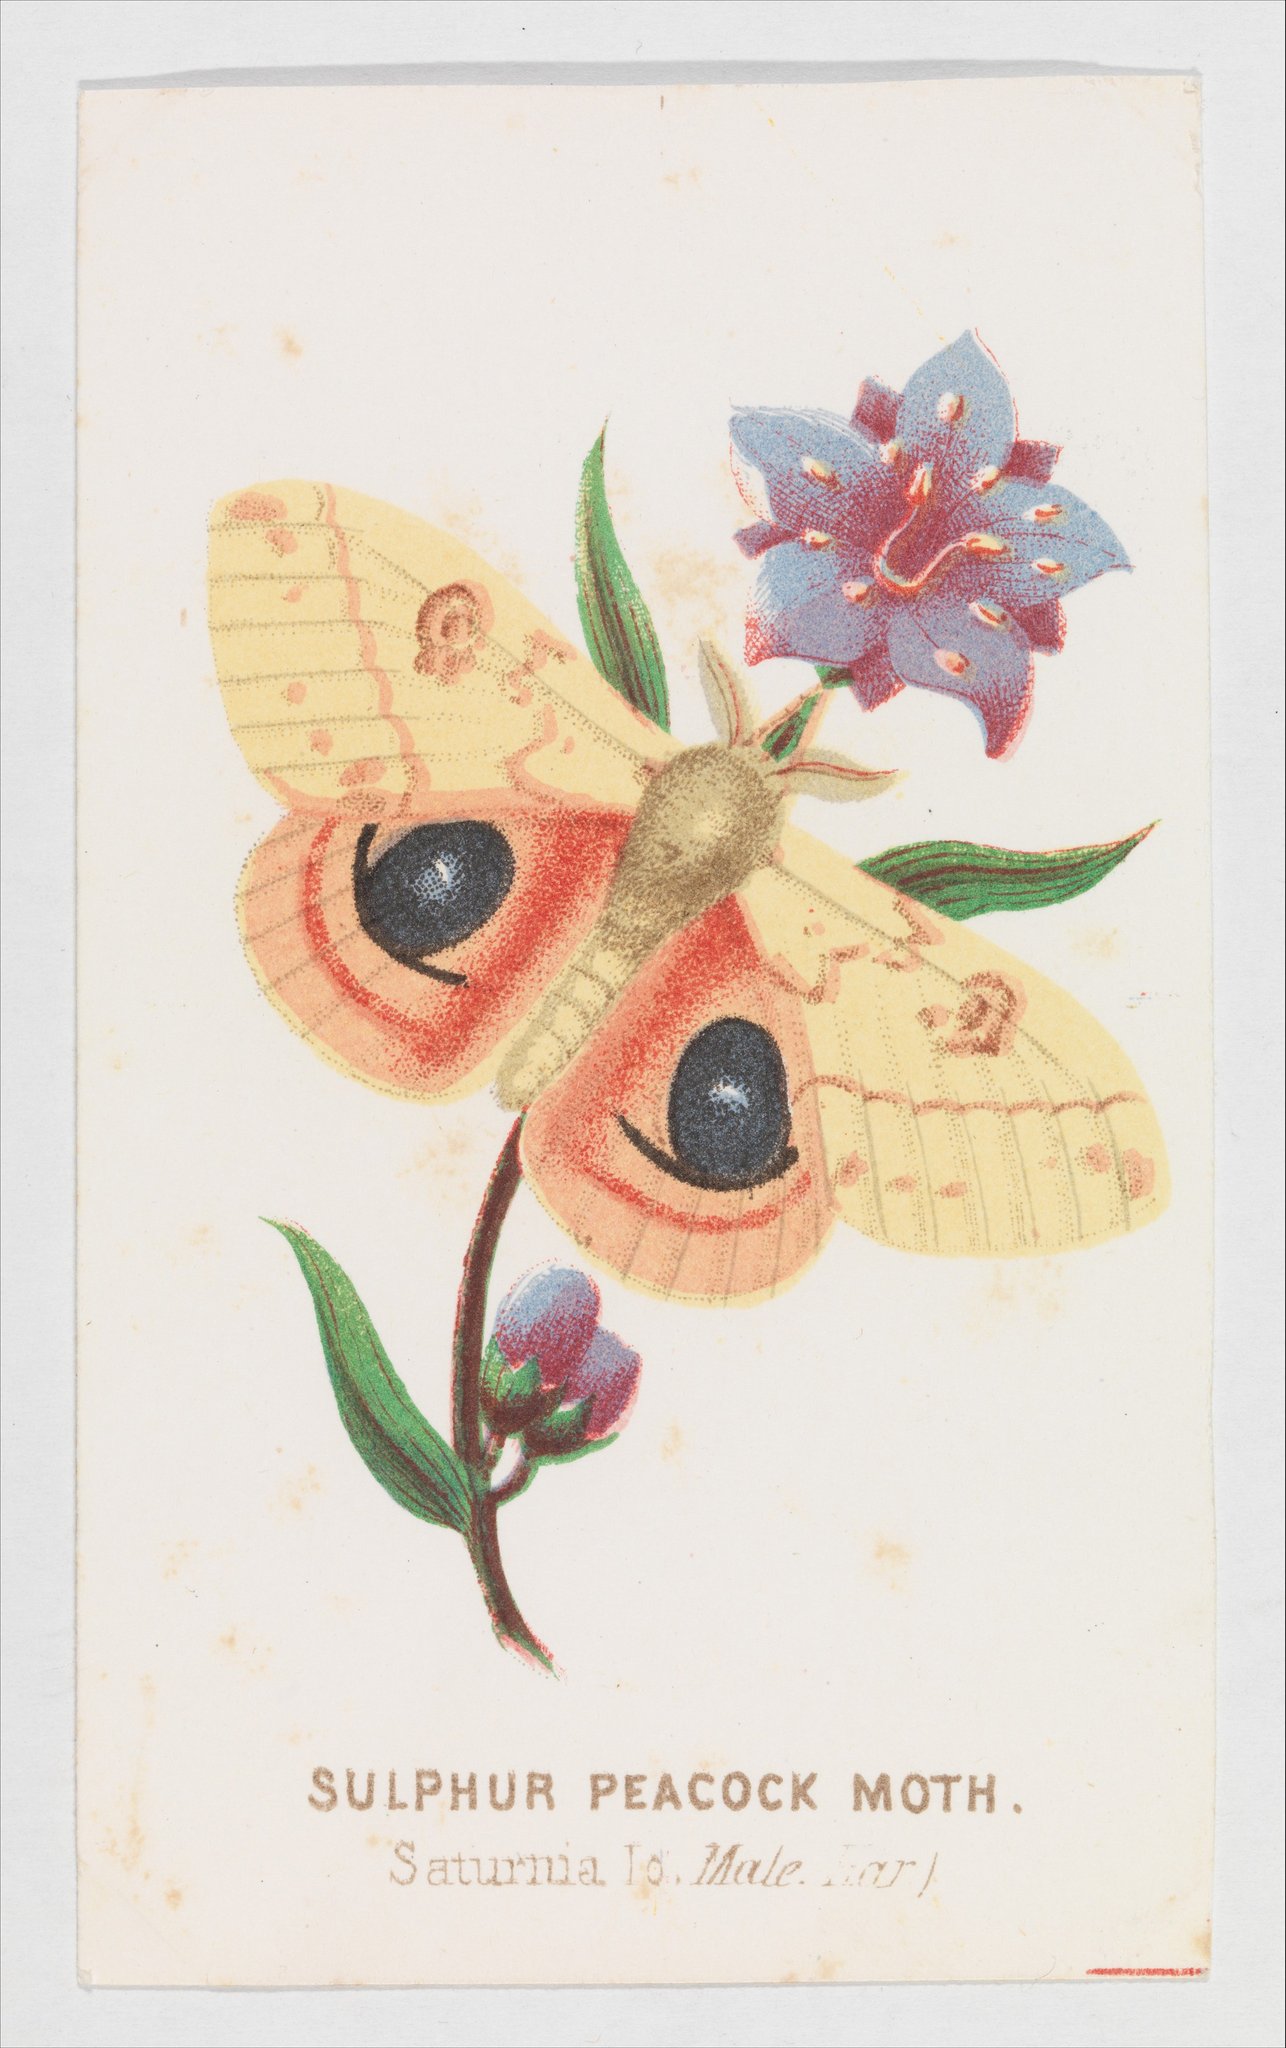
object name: print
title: Sulfur Peacock Moth from "The Butterflies and Moths of America" Part 2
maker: louis prang & co.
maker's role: publisher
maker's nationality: american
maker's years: 1800-1950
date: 1862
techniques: lithograph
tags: butterflies